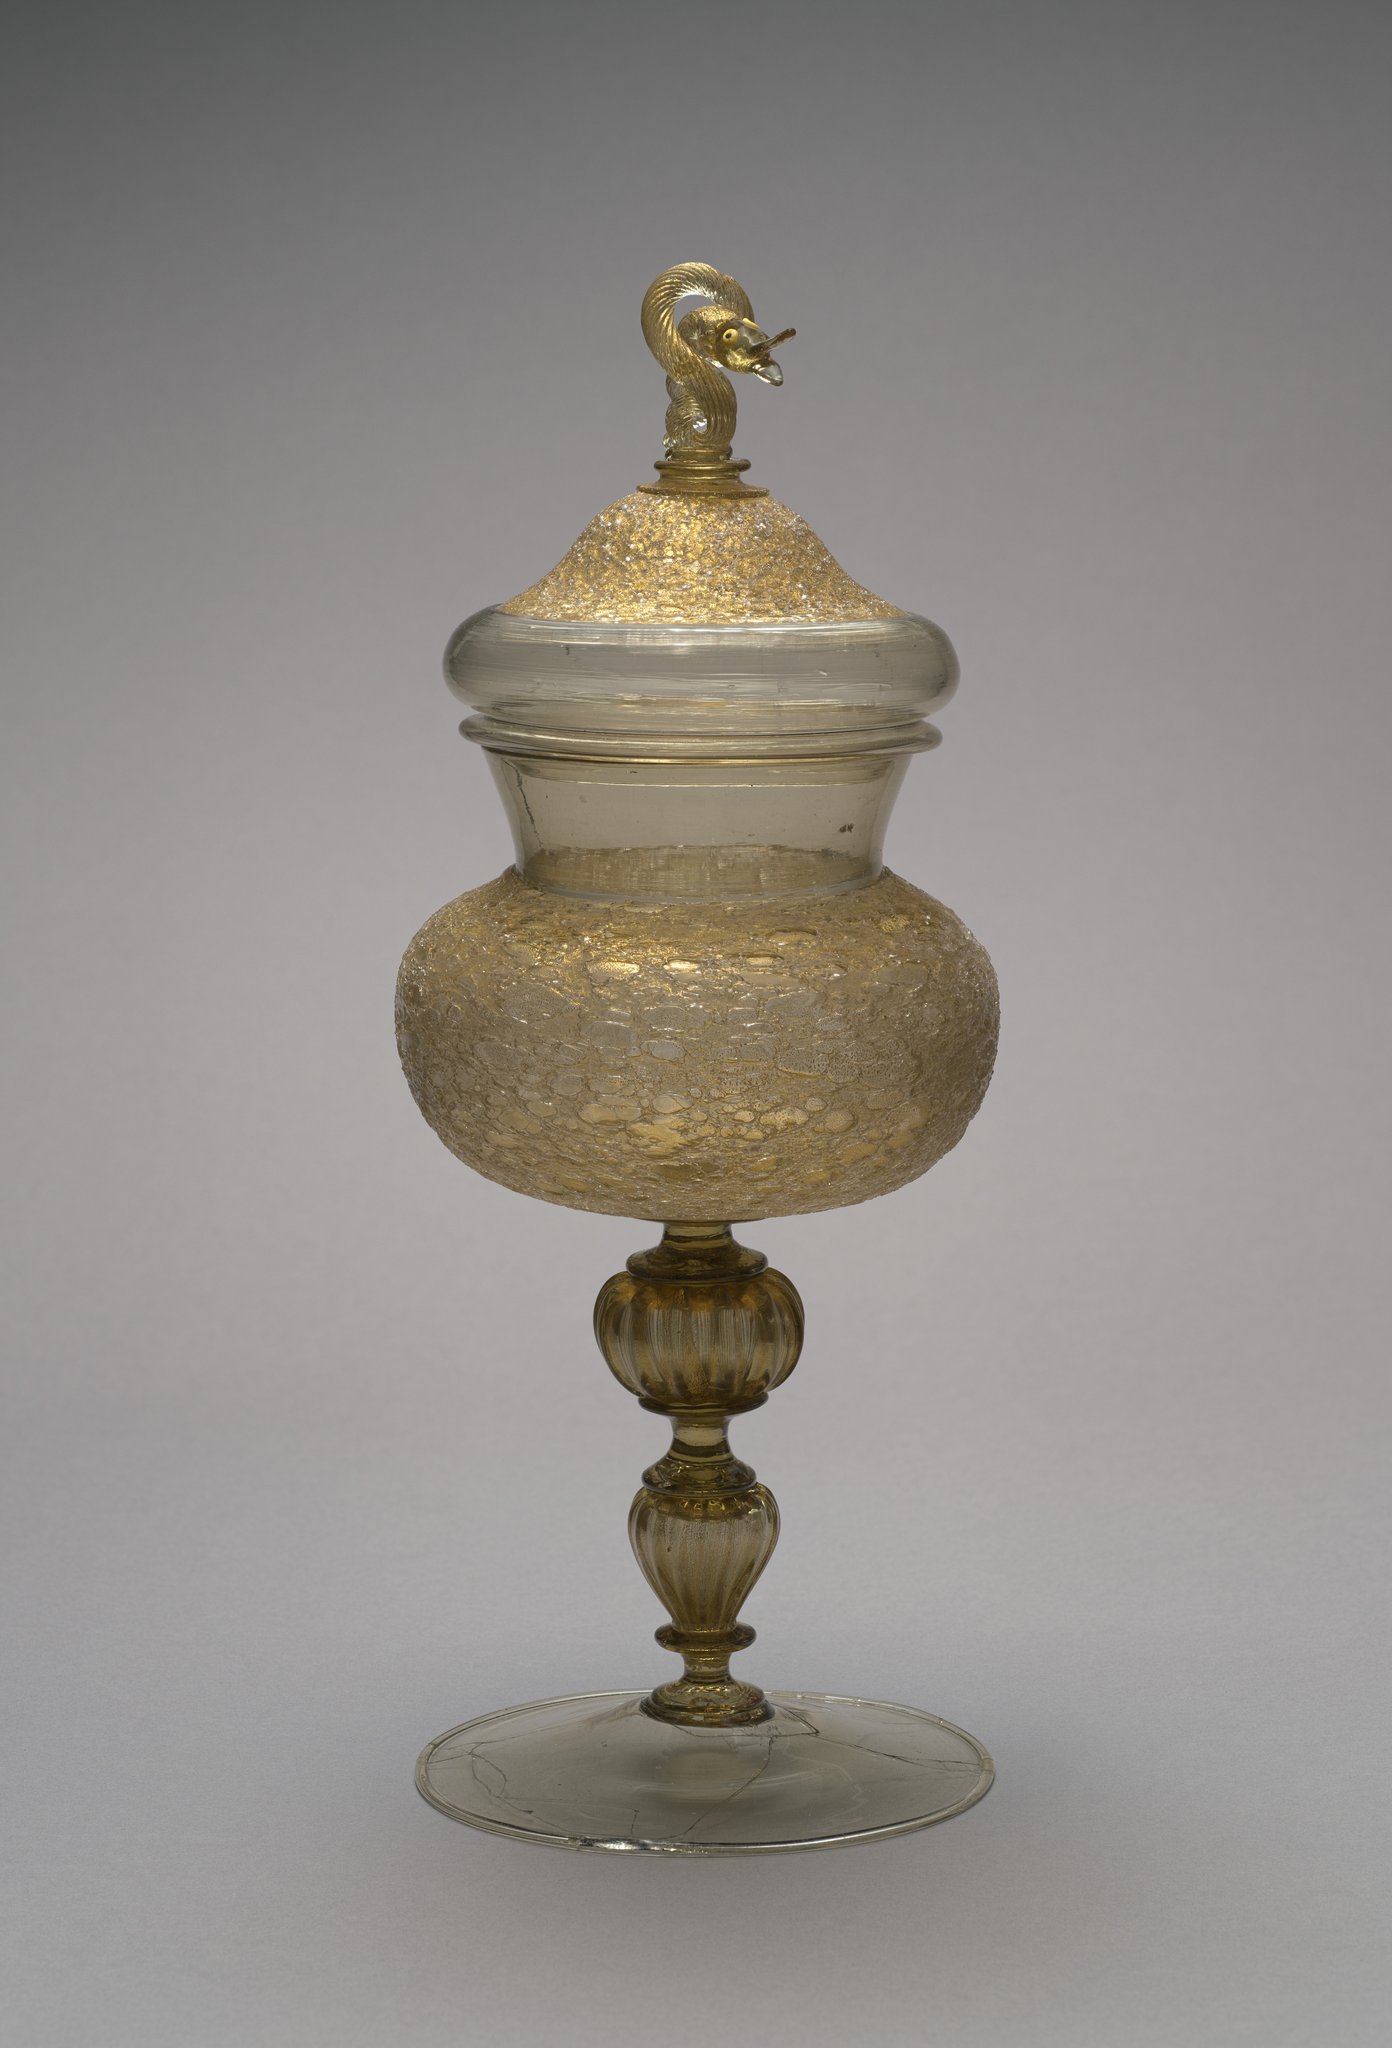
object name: standing cup with cover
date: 1855-1875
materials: glass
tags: snakes